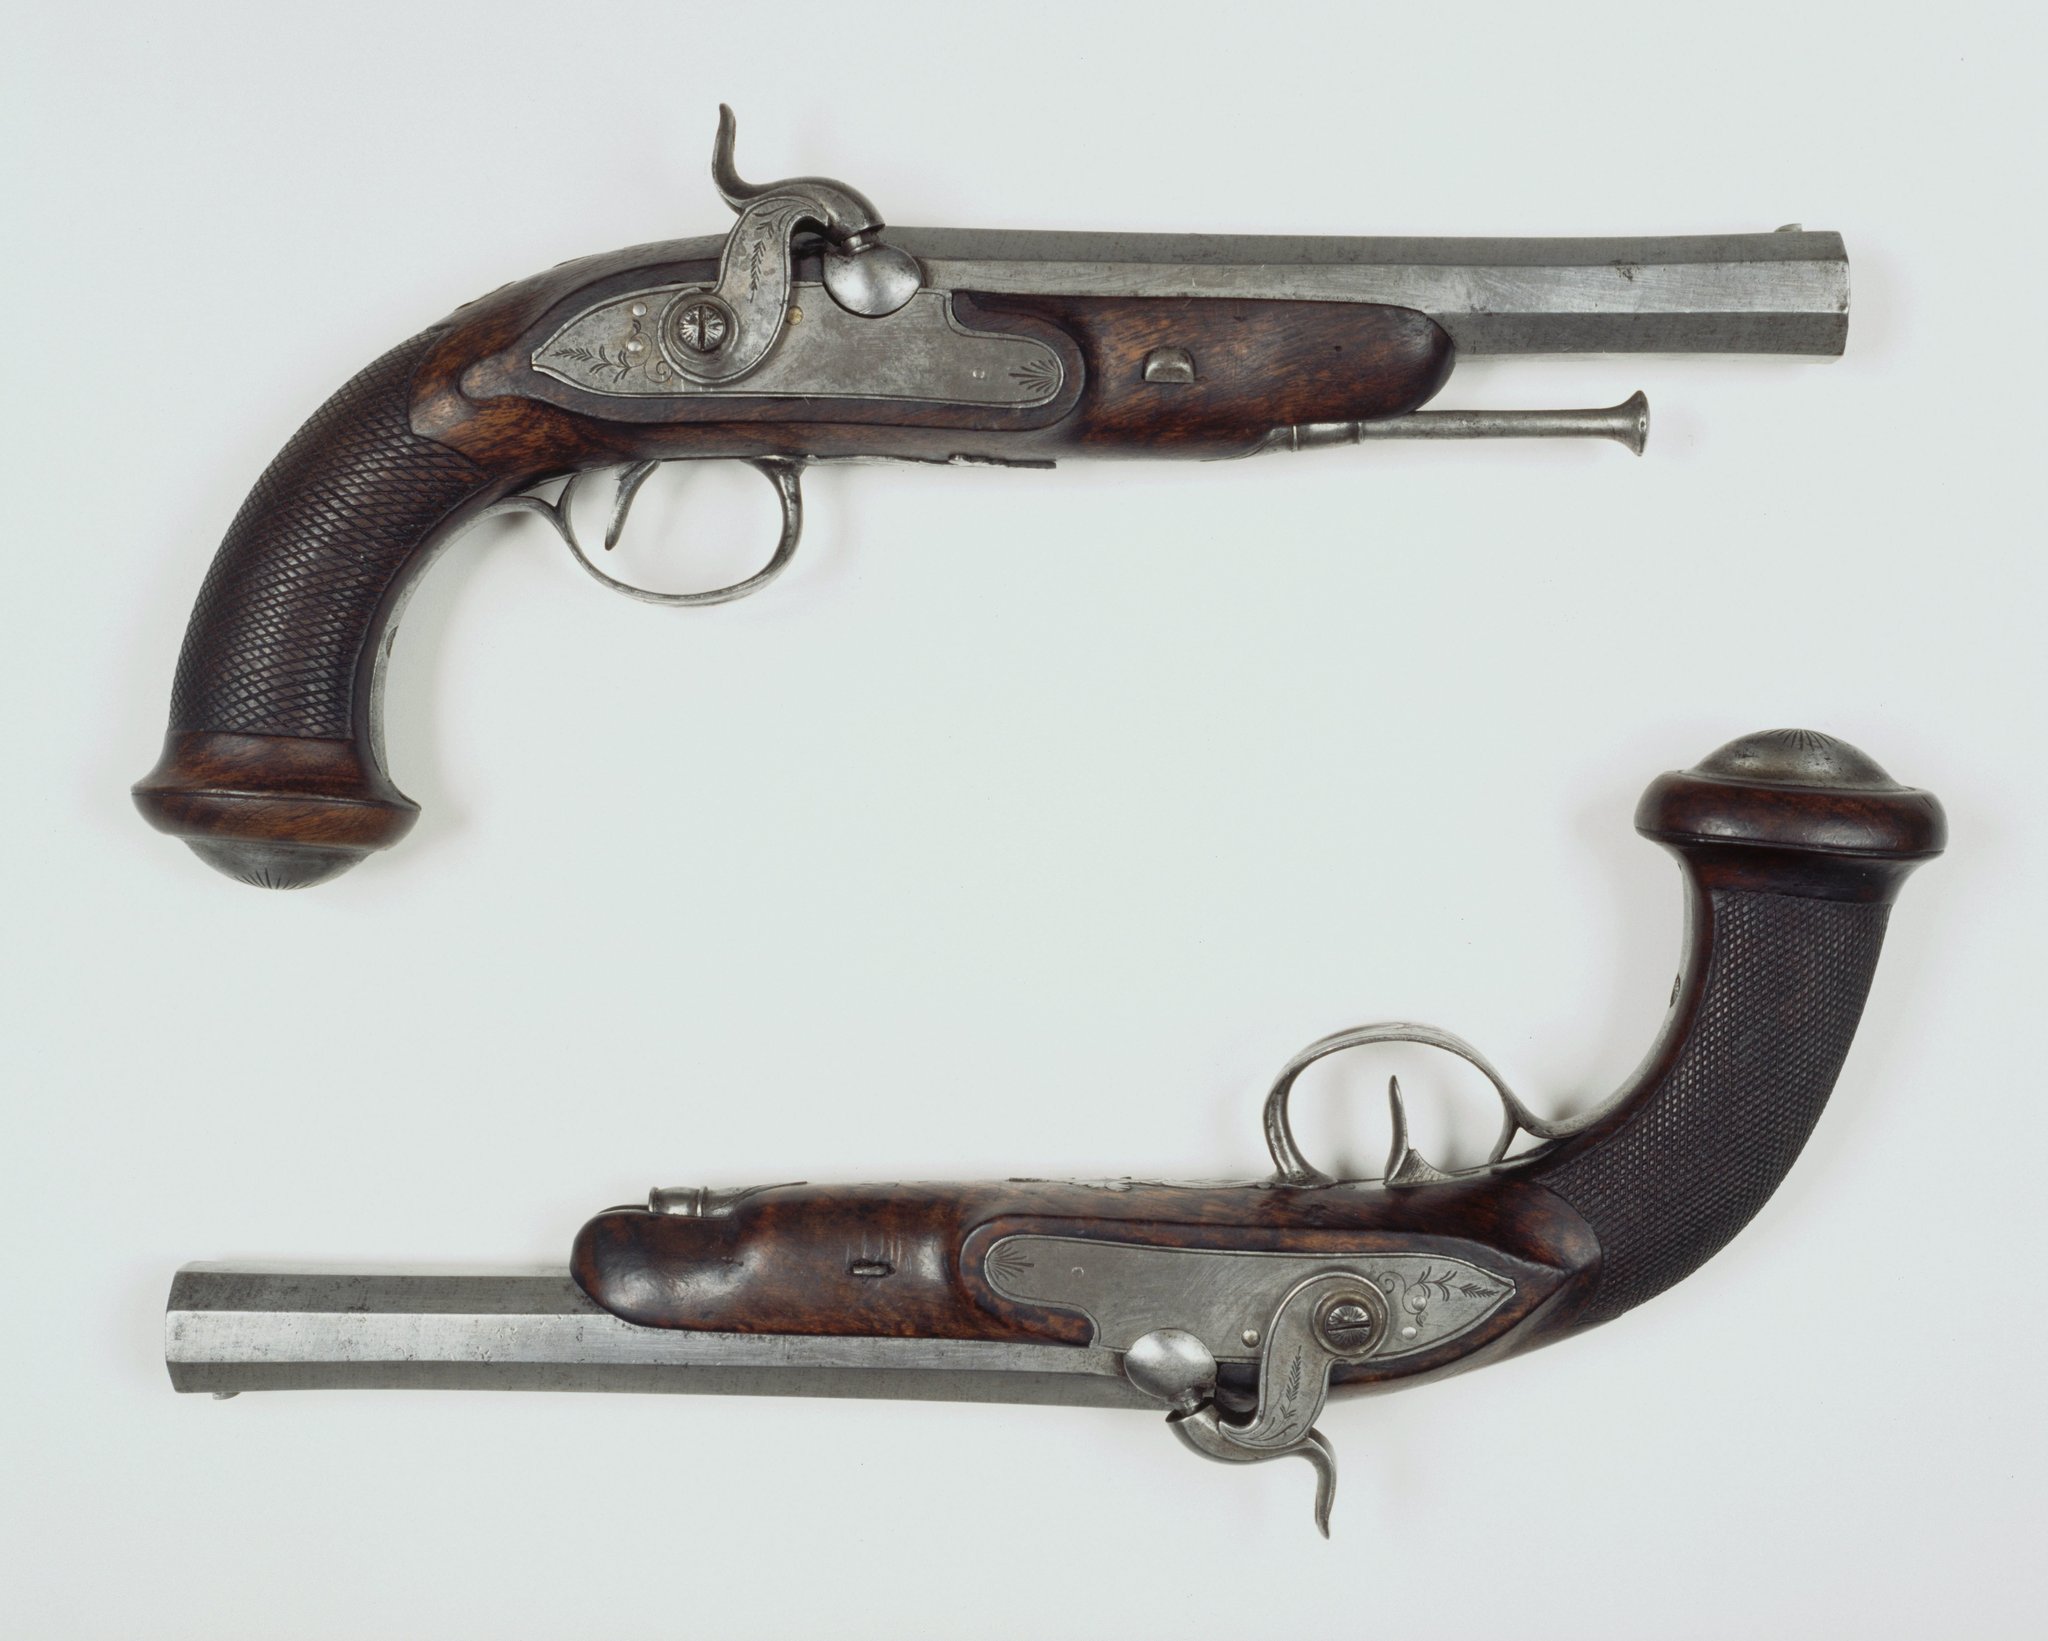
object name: percussion pistol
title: Percussiepistool voor officieren van J.A. Baron de Vos van Steenwijk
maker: Anonymous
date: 1820-1840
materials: alloy, iron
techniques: engraving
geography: liège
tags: luitenant, jagermeester, jan arend baron de vos van steenwijk, hasselt (belgisch-limburg), tiendaagse veldtocht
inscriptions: mark: ‘E // LG’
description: Percussiepistool, deel van koppel, met achthoekige getrokken loop. De kolf is van notenhout en heeft een ruitgegroefde greep, onder de kolf een ijzeren kolfplaat met een ingekerfde stermotief. De loop ligt in een halve lade van notenhout. Het ijzeren slot is plat en heeft aan weerzijden gegraveerde bloemmotieven. De haan is eveneens gegraveerd. Aan het uiteinde van de gordelhaak een gegroefde inkeping voor de duim. De trekkerbeugel is van ijzer en heeft over de gehele lengte bloemversieringen. De laadstokkoker is van ijzer maar de laadstok ontbreekt. Op de loop het Luikse keurmerk E.L.G..